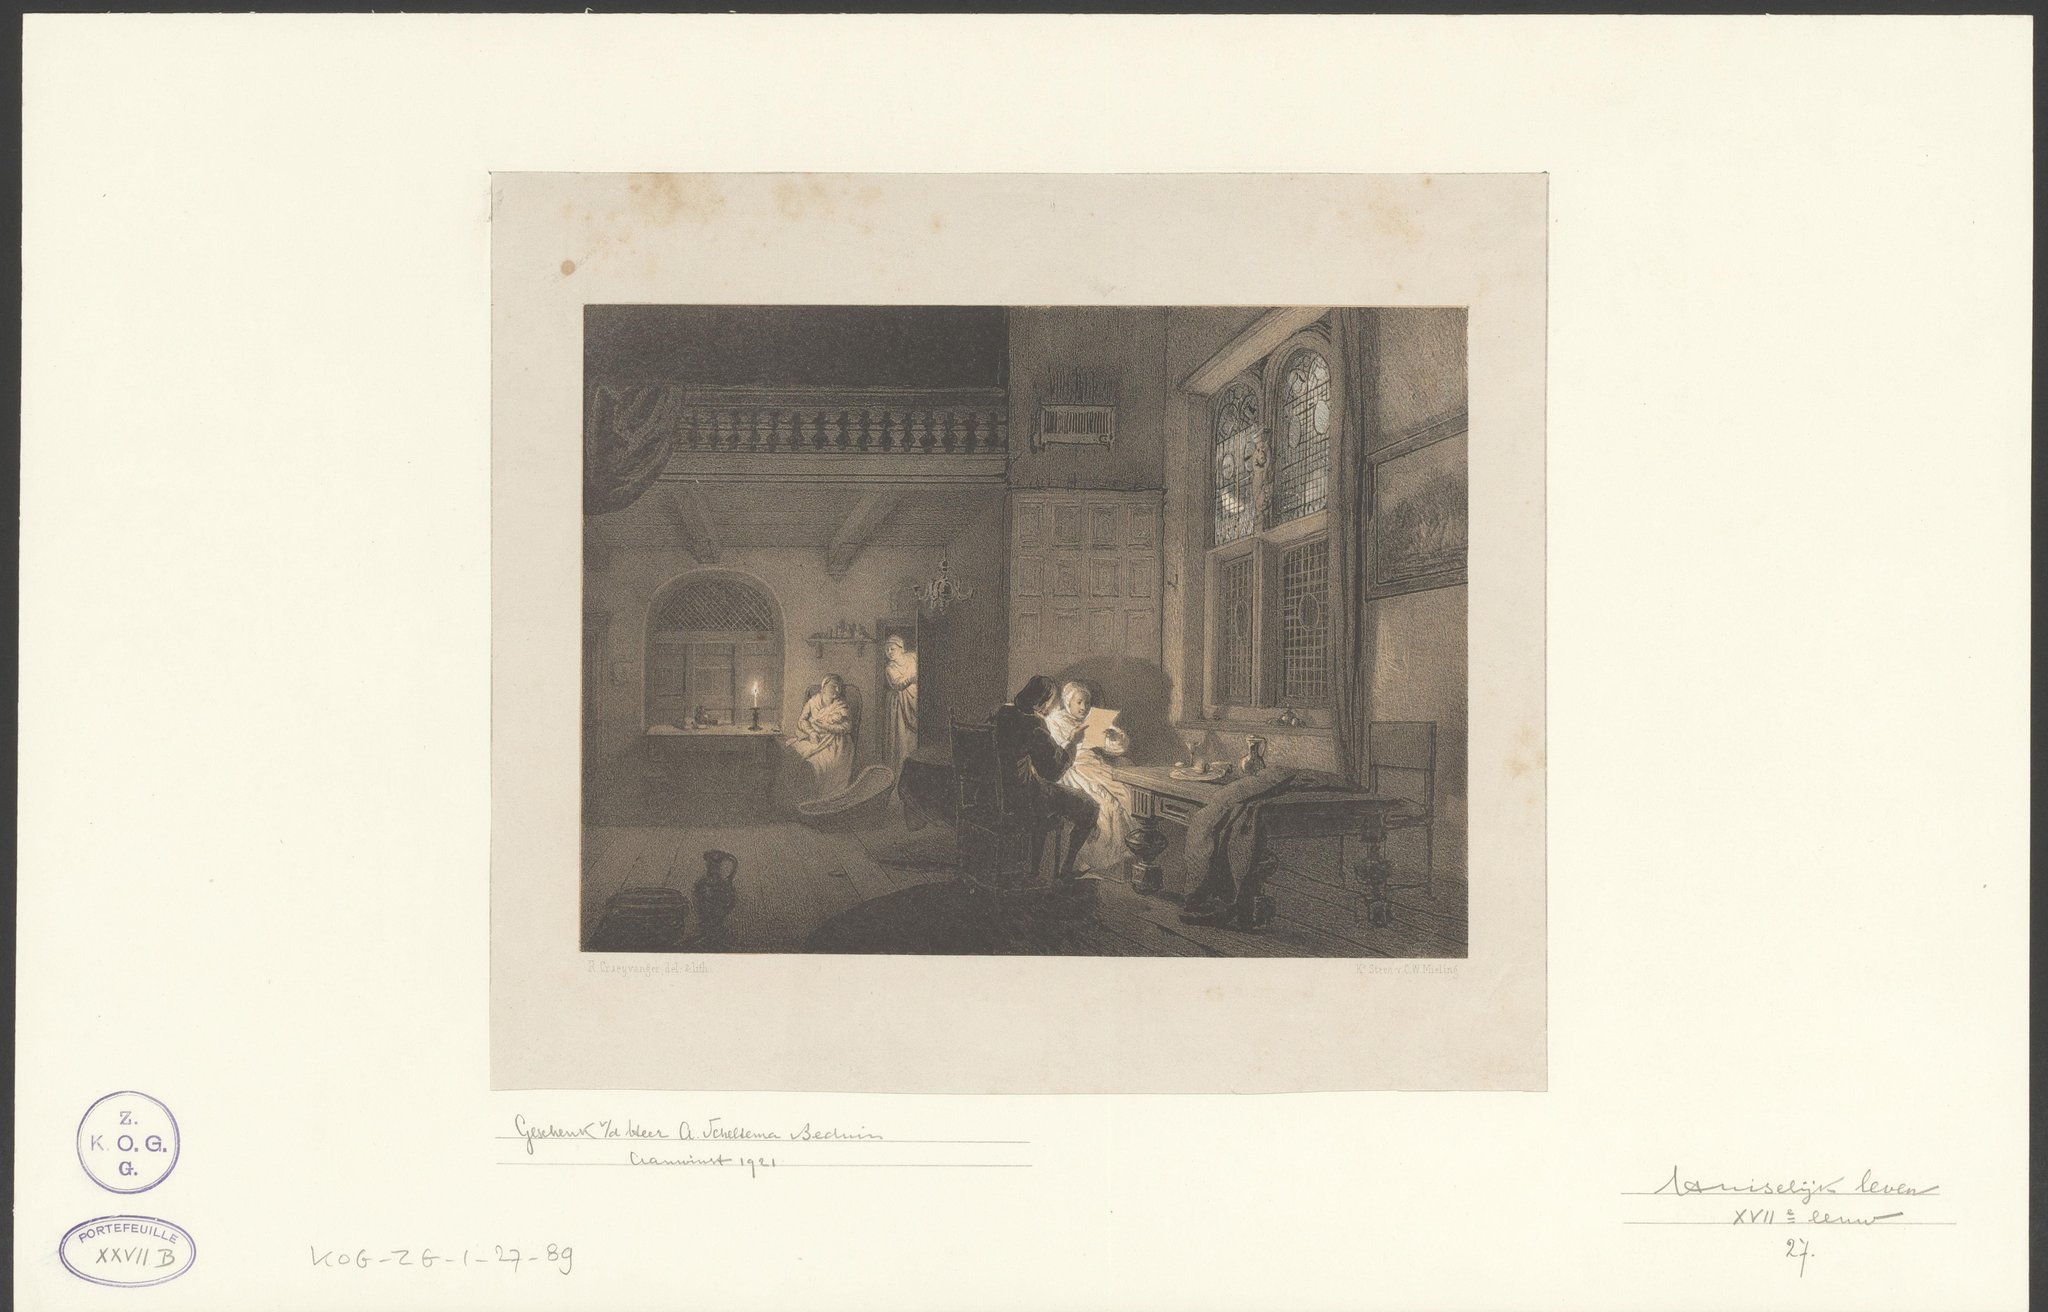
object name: print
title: Binnenkamer bij avond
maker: reinier craeyvanger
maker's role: draughtsman, print maker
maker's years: 1812-1880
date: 1851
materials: paper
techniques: tone lithography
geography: the hague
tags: reading, candle, communal rooms, family life at home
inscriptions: collector's mark, collector's mark: Lugt 1641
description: Deze prent werd gepubliceerd in De Kunstkronijk in 1851.